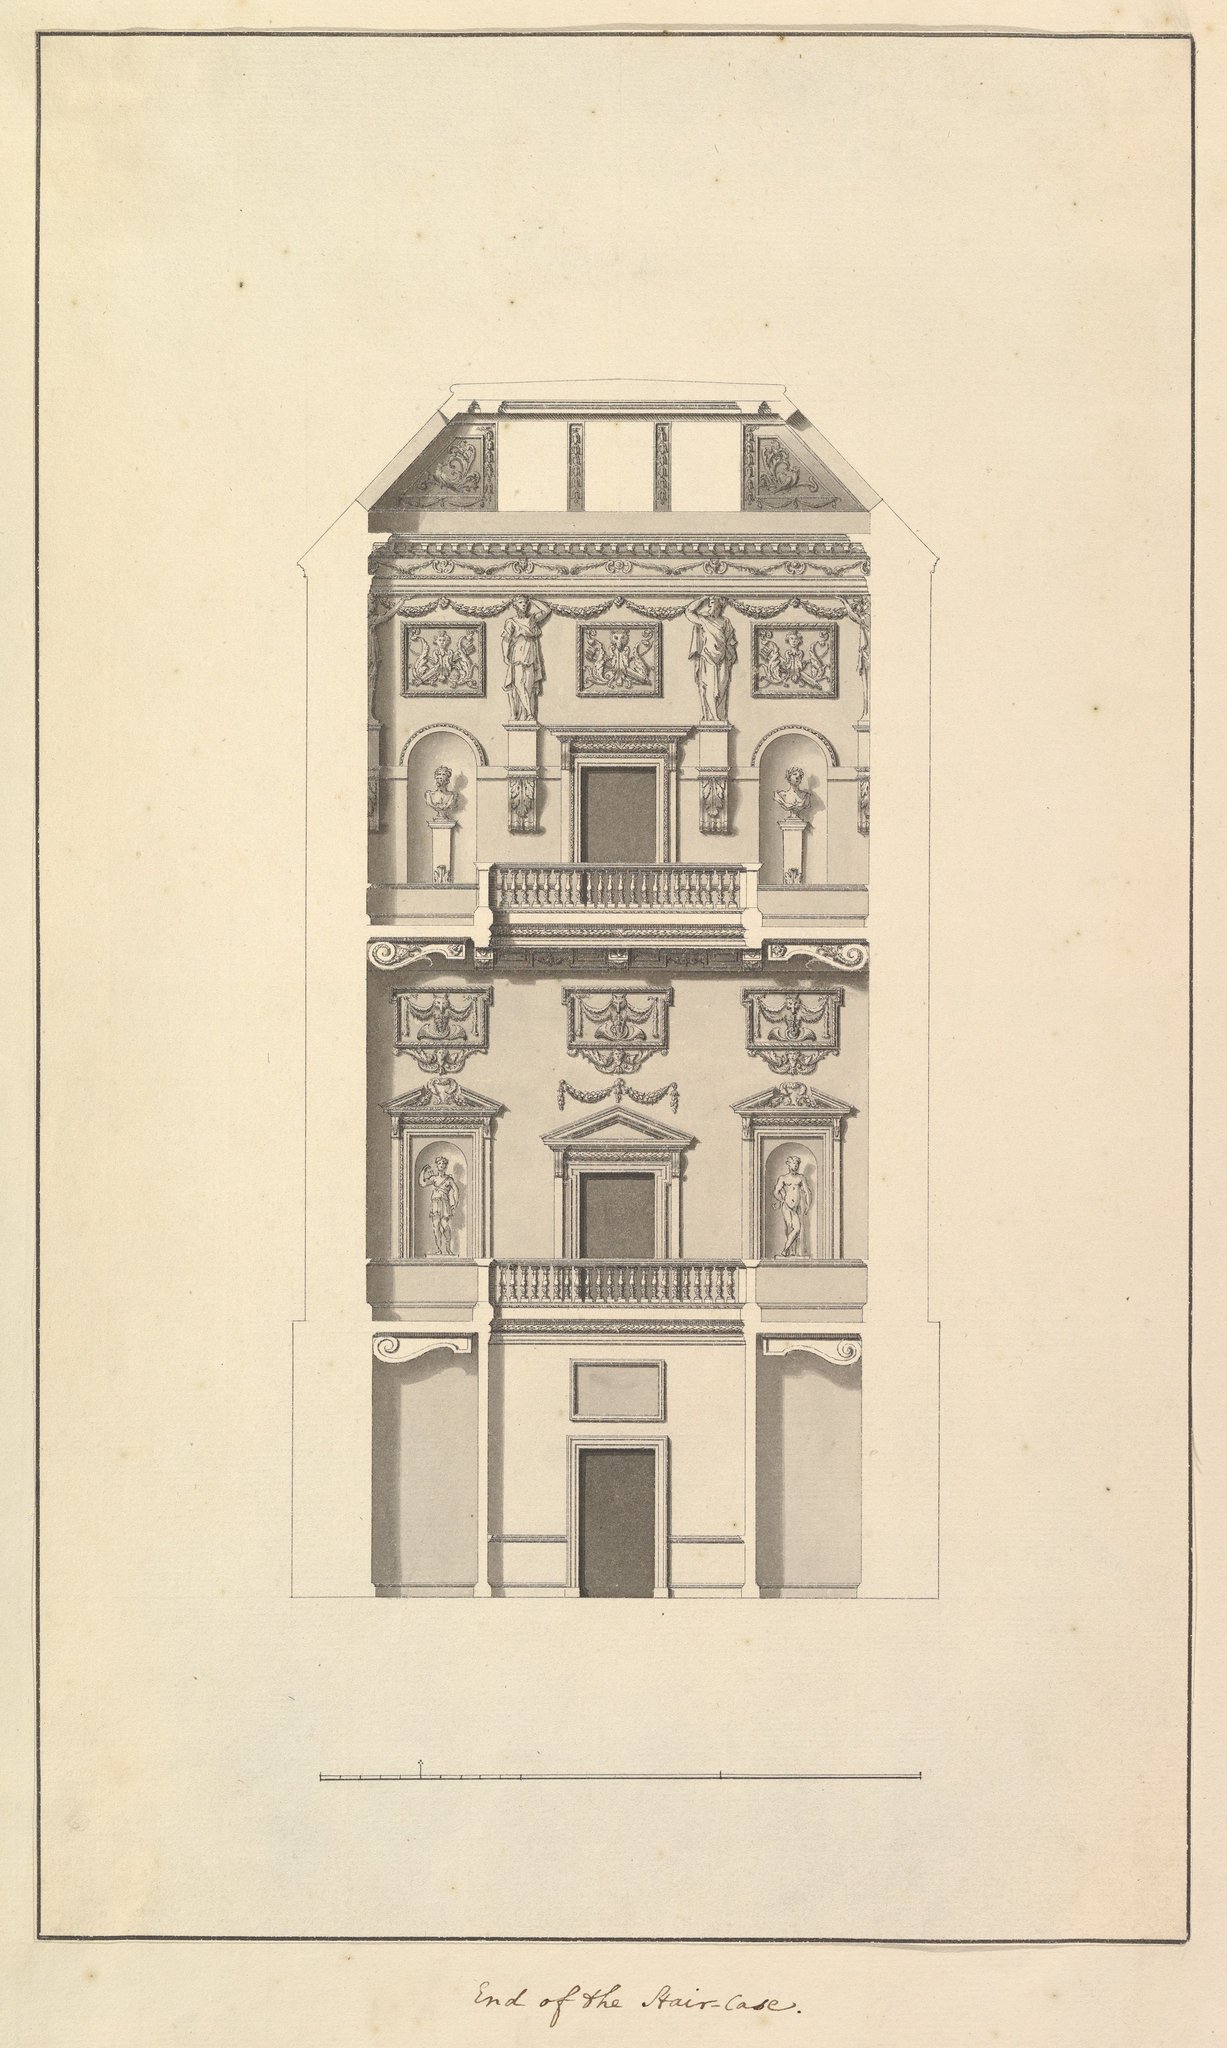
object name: drawing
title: End of Staircase, Houghton Hall, Norfolk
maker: isaac ware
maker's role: artist and architect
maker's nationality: british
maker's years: 1704-1766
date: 1735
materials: ink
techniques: brush, pen, wash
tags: architecture